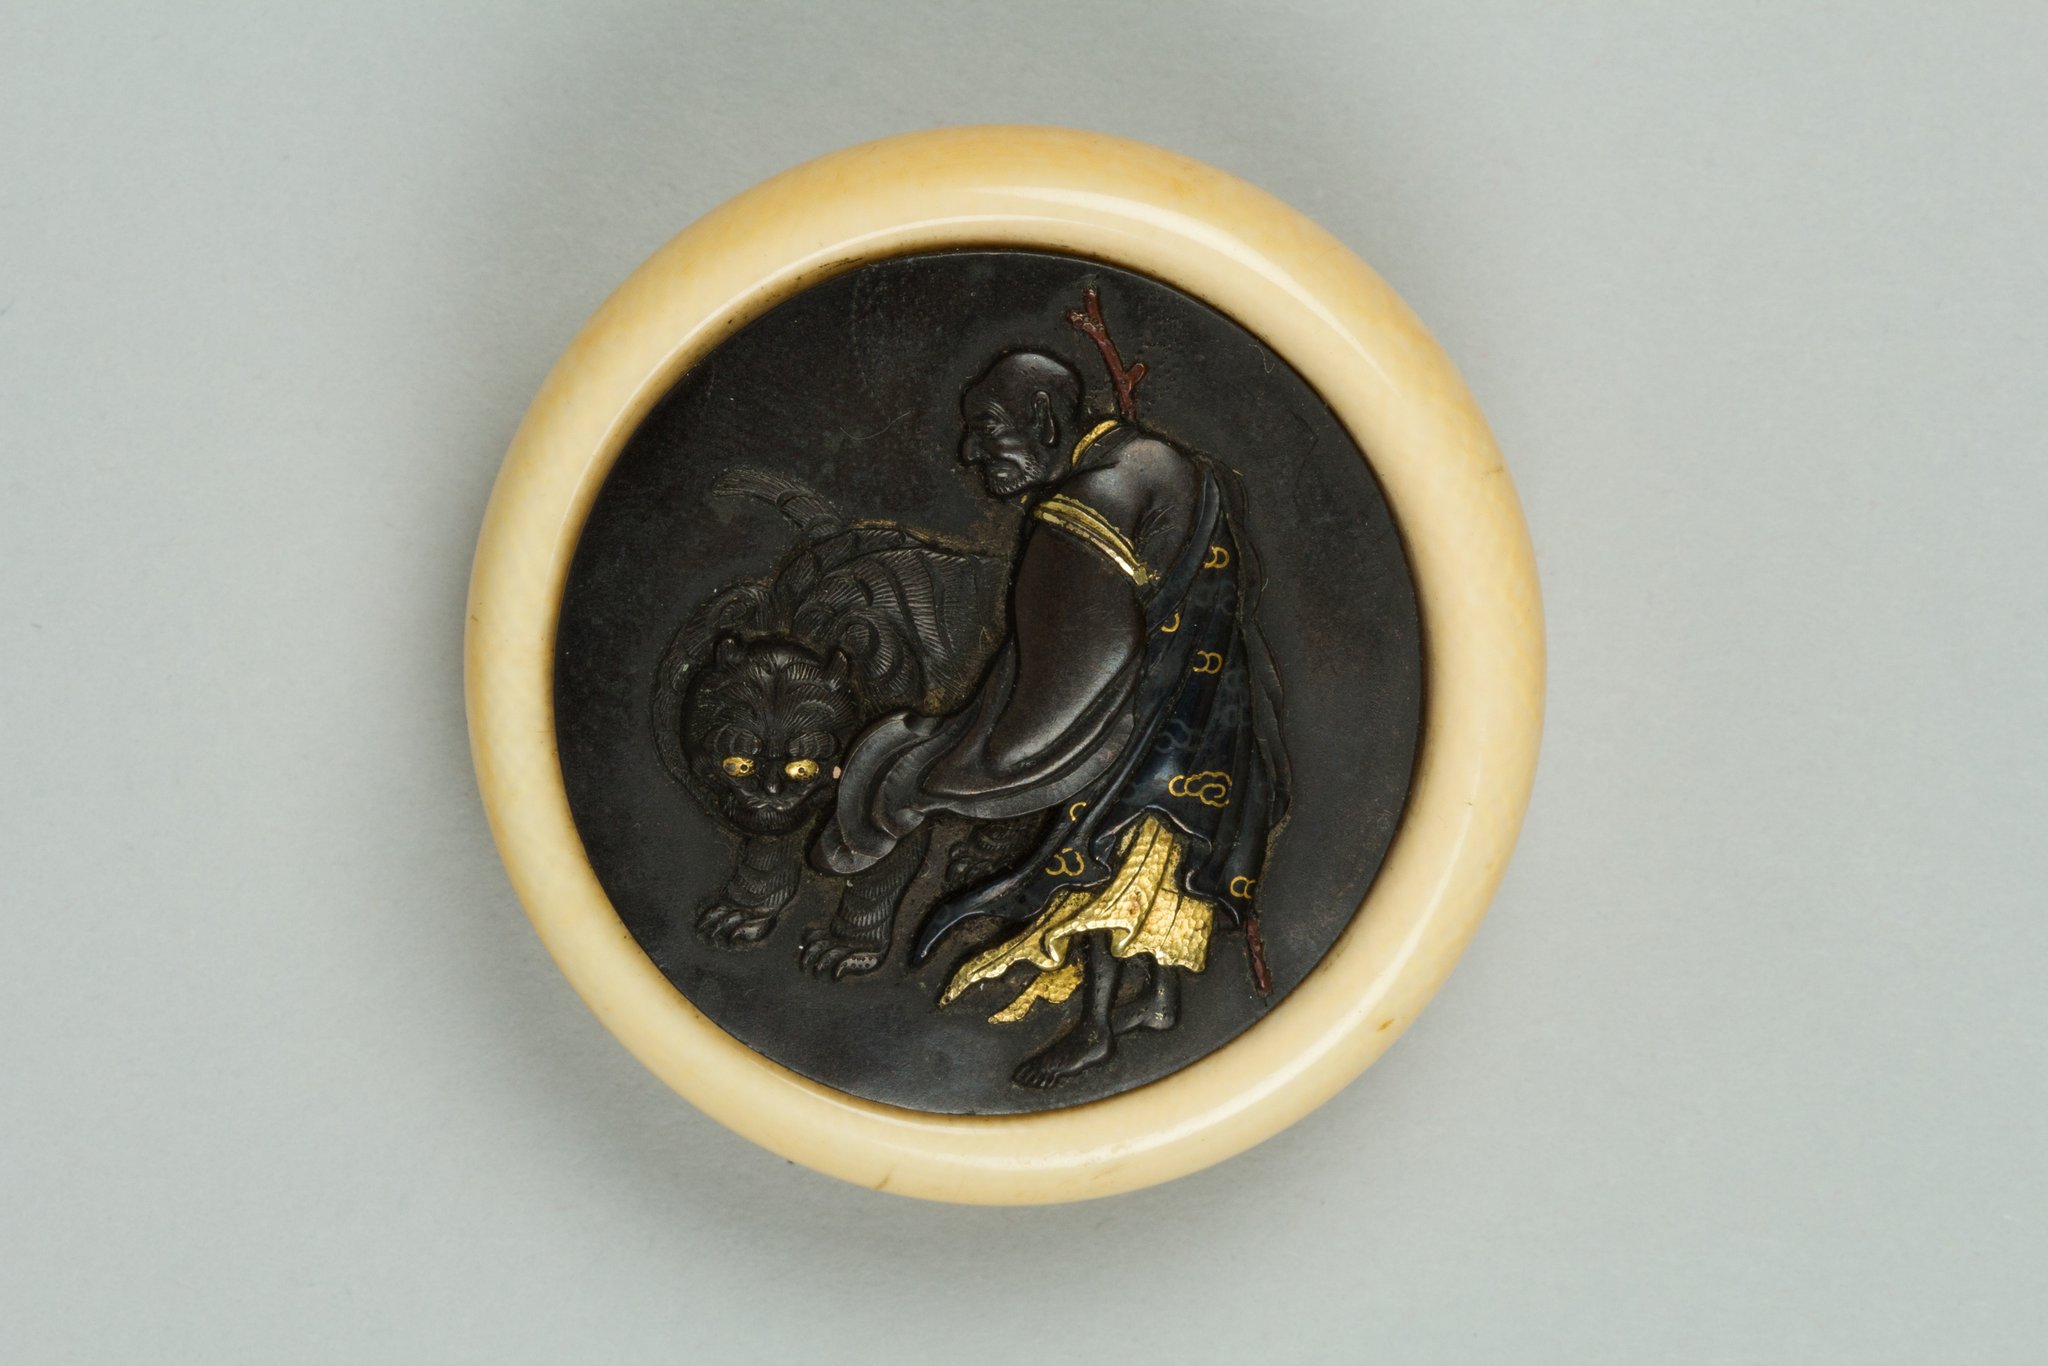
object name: netsuke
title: Netsuke of Luohan with a Tiger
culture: japanese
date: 1801-1900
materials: ivory, metal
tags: men,tigers